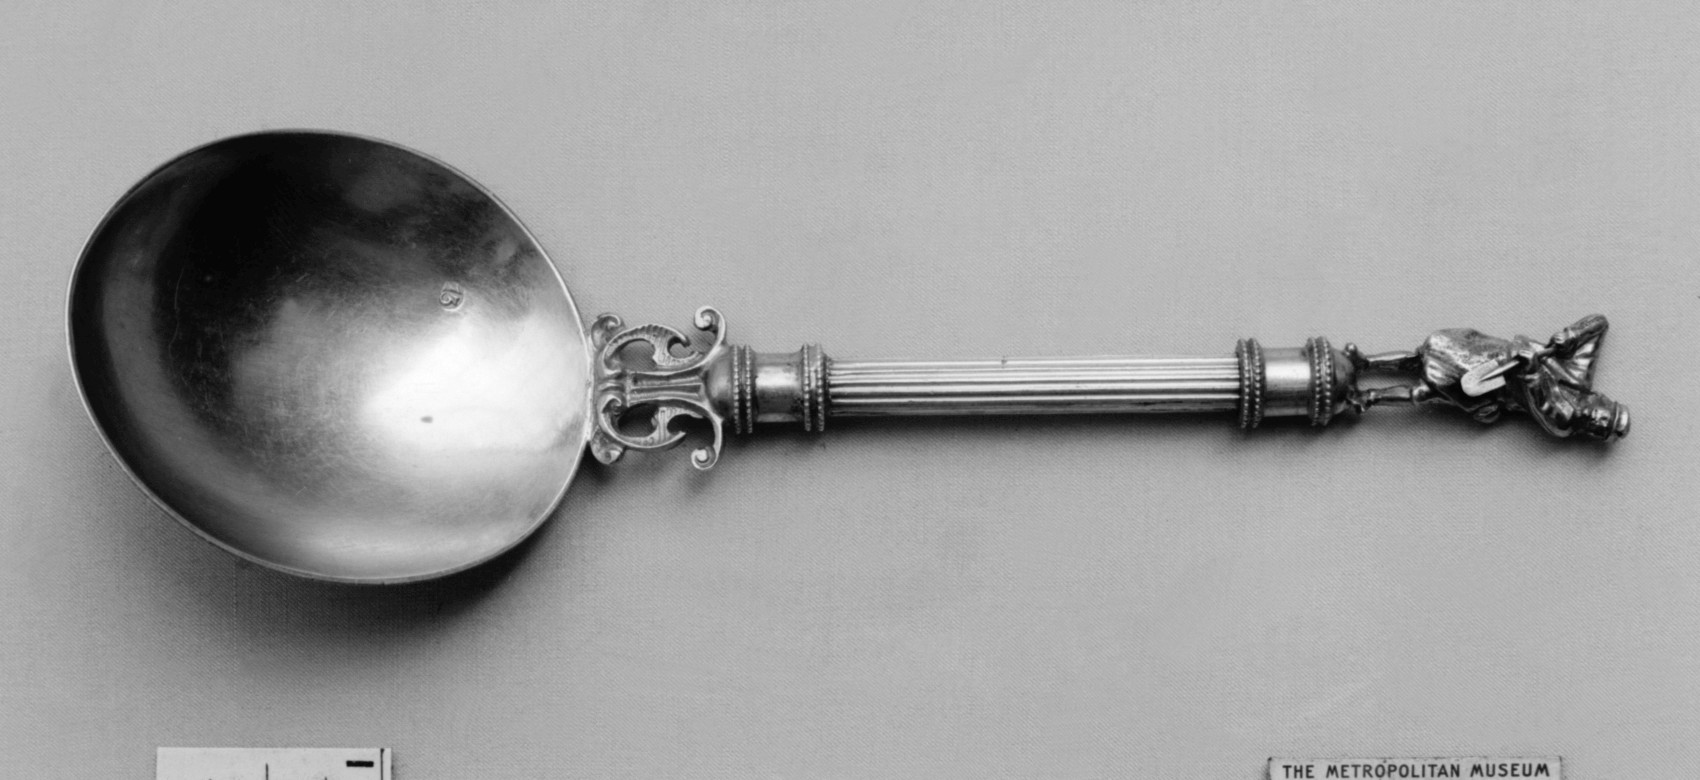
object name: spoon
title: Figure-top spoon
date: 1567-1633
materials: gilt, silver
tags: men